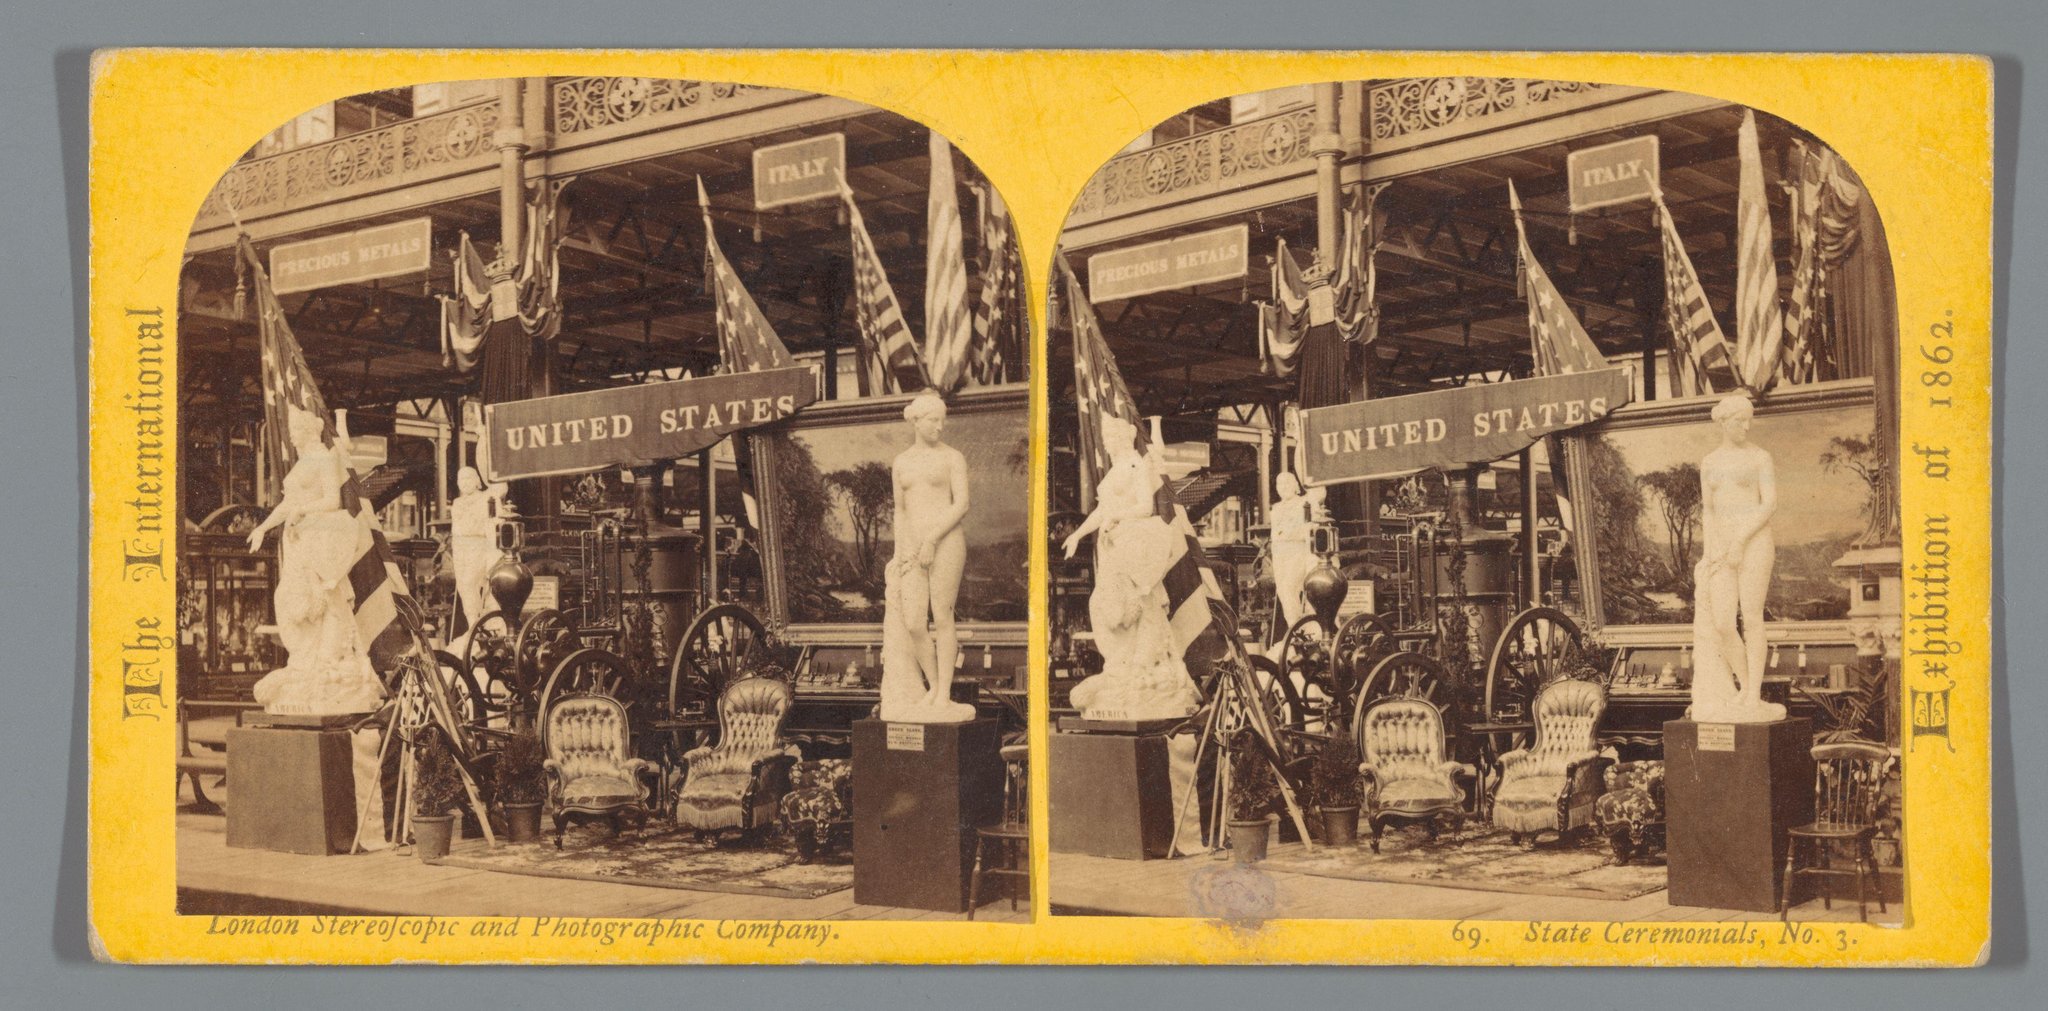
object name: stereograph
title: The International Exhibition of 1862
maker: william england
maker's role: fotograaf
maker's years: 1816-1896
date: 1862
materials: cardboard, paper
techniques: albumen print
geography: london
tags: world fair, world exhibition, london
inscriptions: inscription: ‘ü’, number: ‘69.’